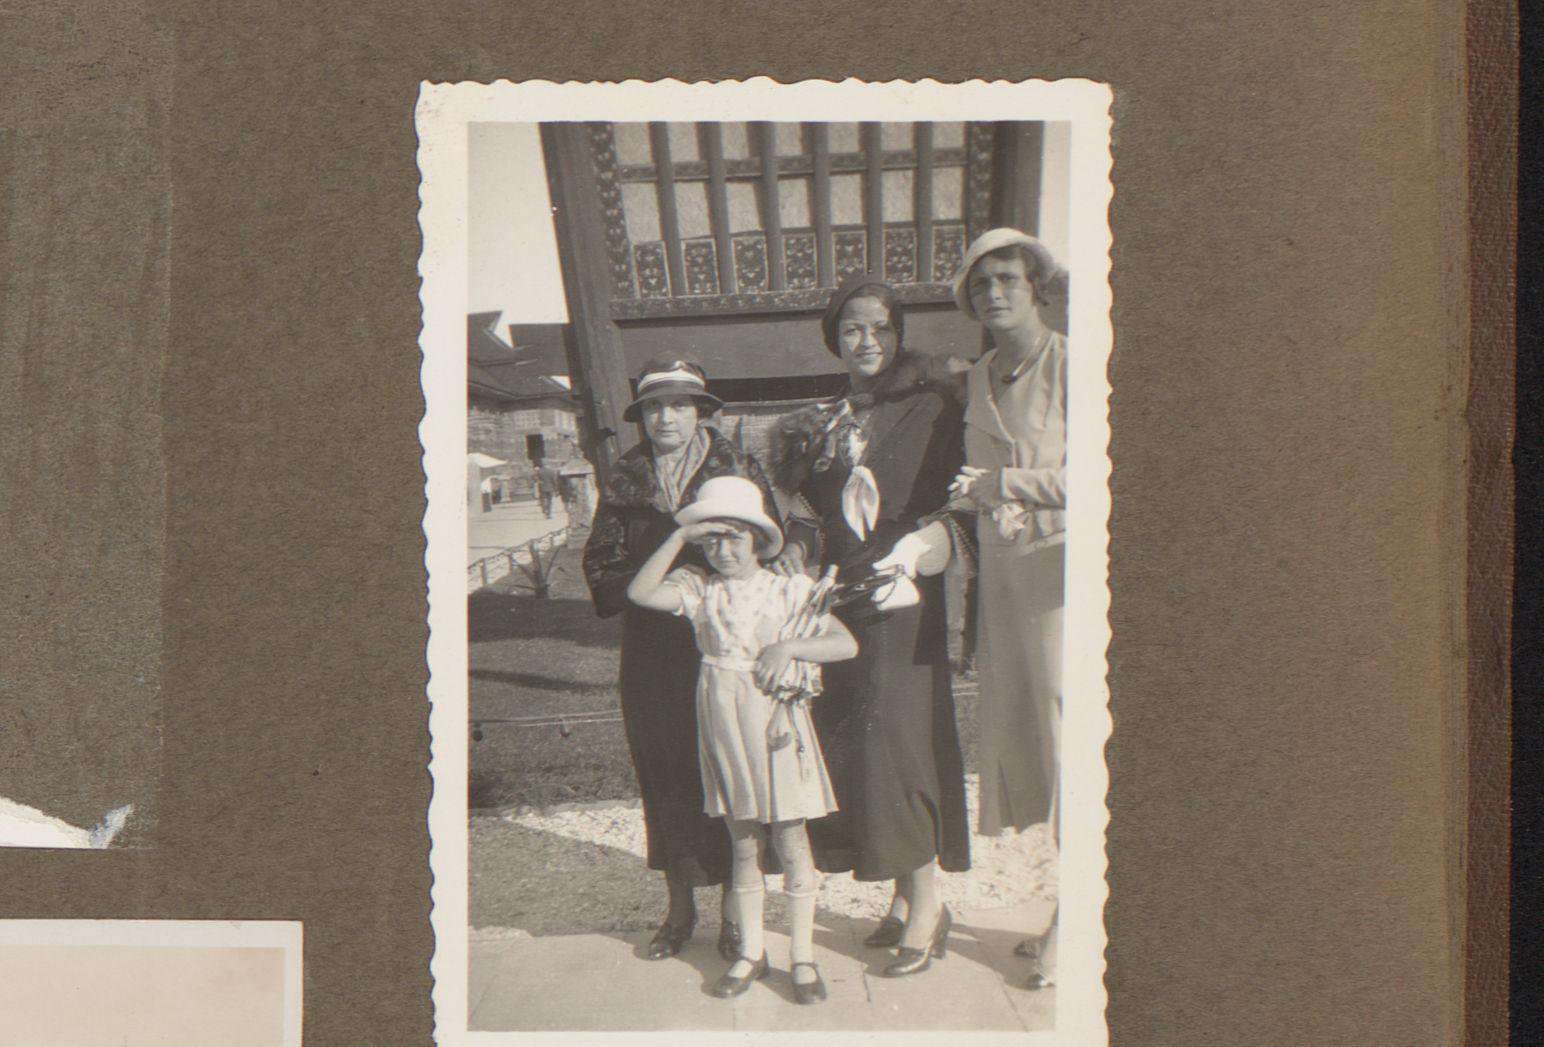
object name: album leaf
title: Groepsportret van drie vrouwen en een meisje op de Indische Tentoonstelling in Den Haag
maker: Anonymous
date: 1932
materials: paper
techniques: gelatin silver print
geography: the hague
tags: historical persons - bb - woman, collection, exhibition, show, the hague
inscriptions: inscription: ‘Mam, ik, Annie Beunink/ Elsje.’